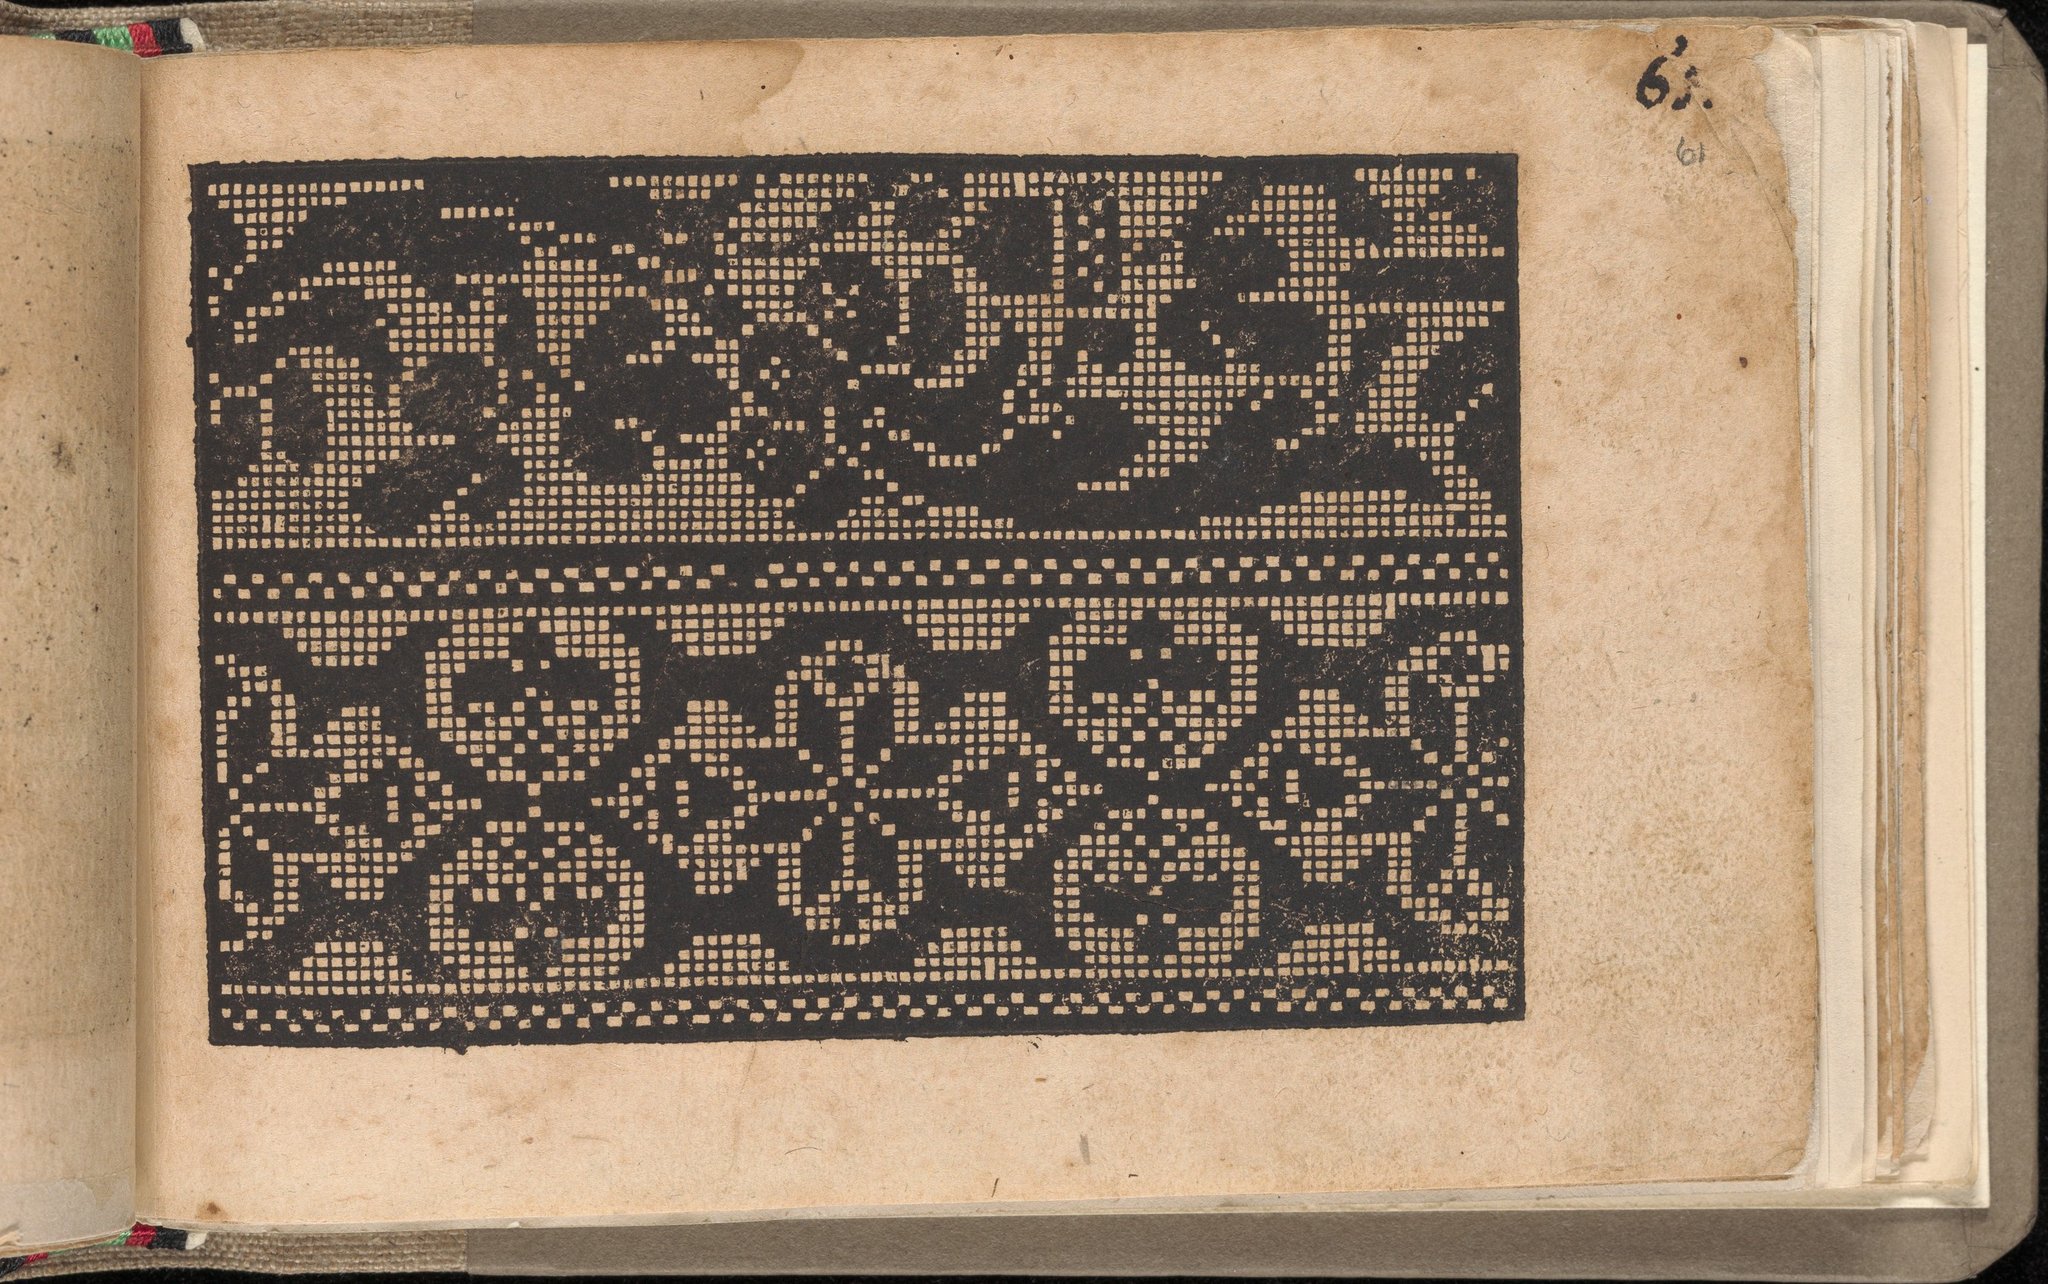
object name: book print ornament architecture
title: Schön newes Modelbuch (Page 61r)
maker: sigismundus latomus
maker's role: publisher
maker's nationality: german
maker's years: 1599-1632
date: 1608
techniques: woodcut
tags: ornament